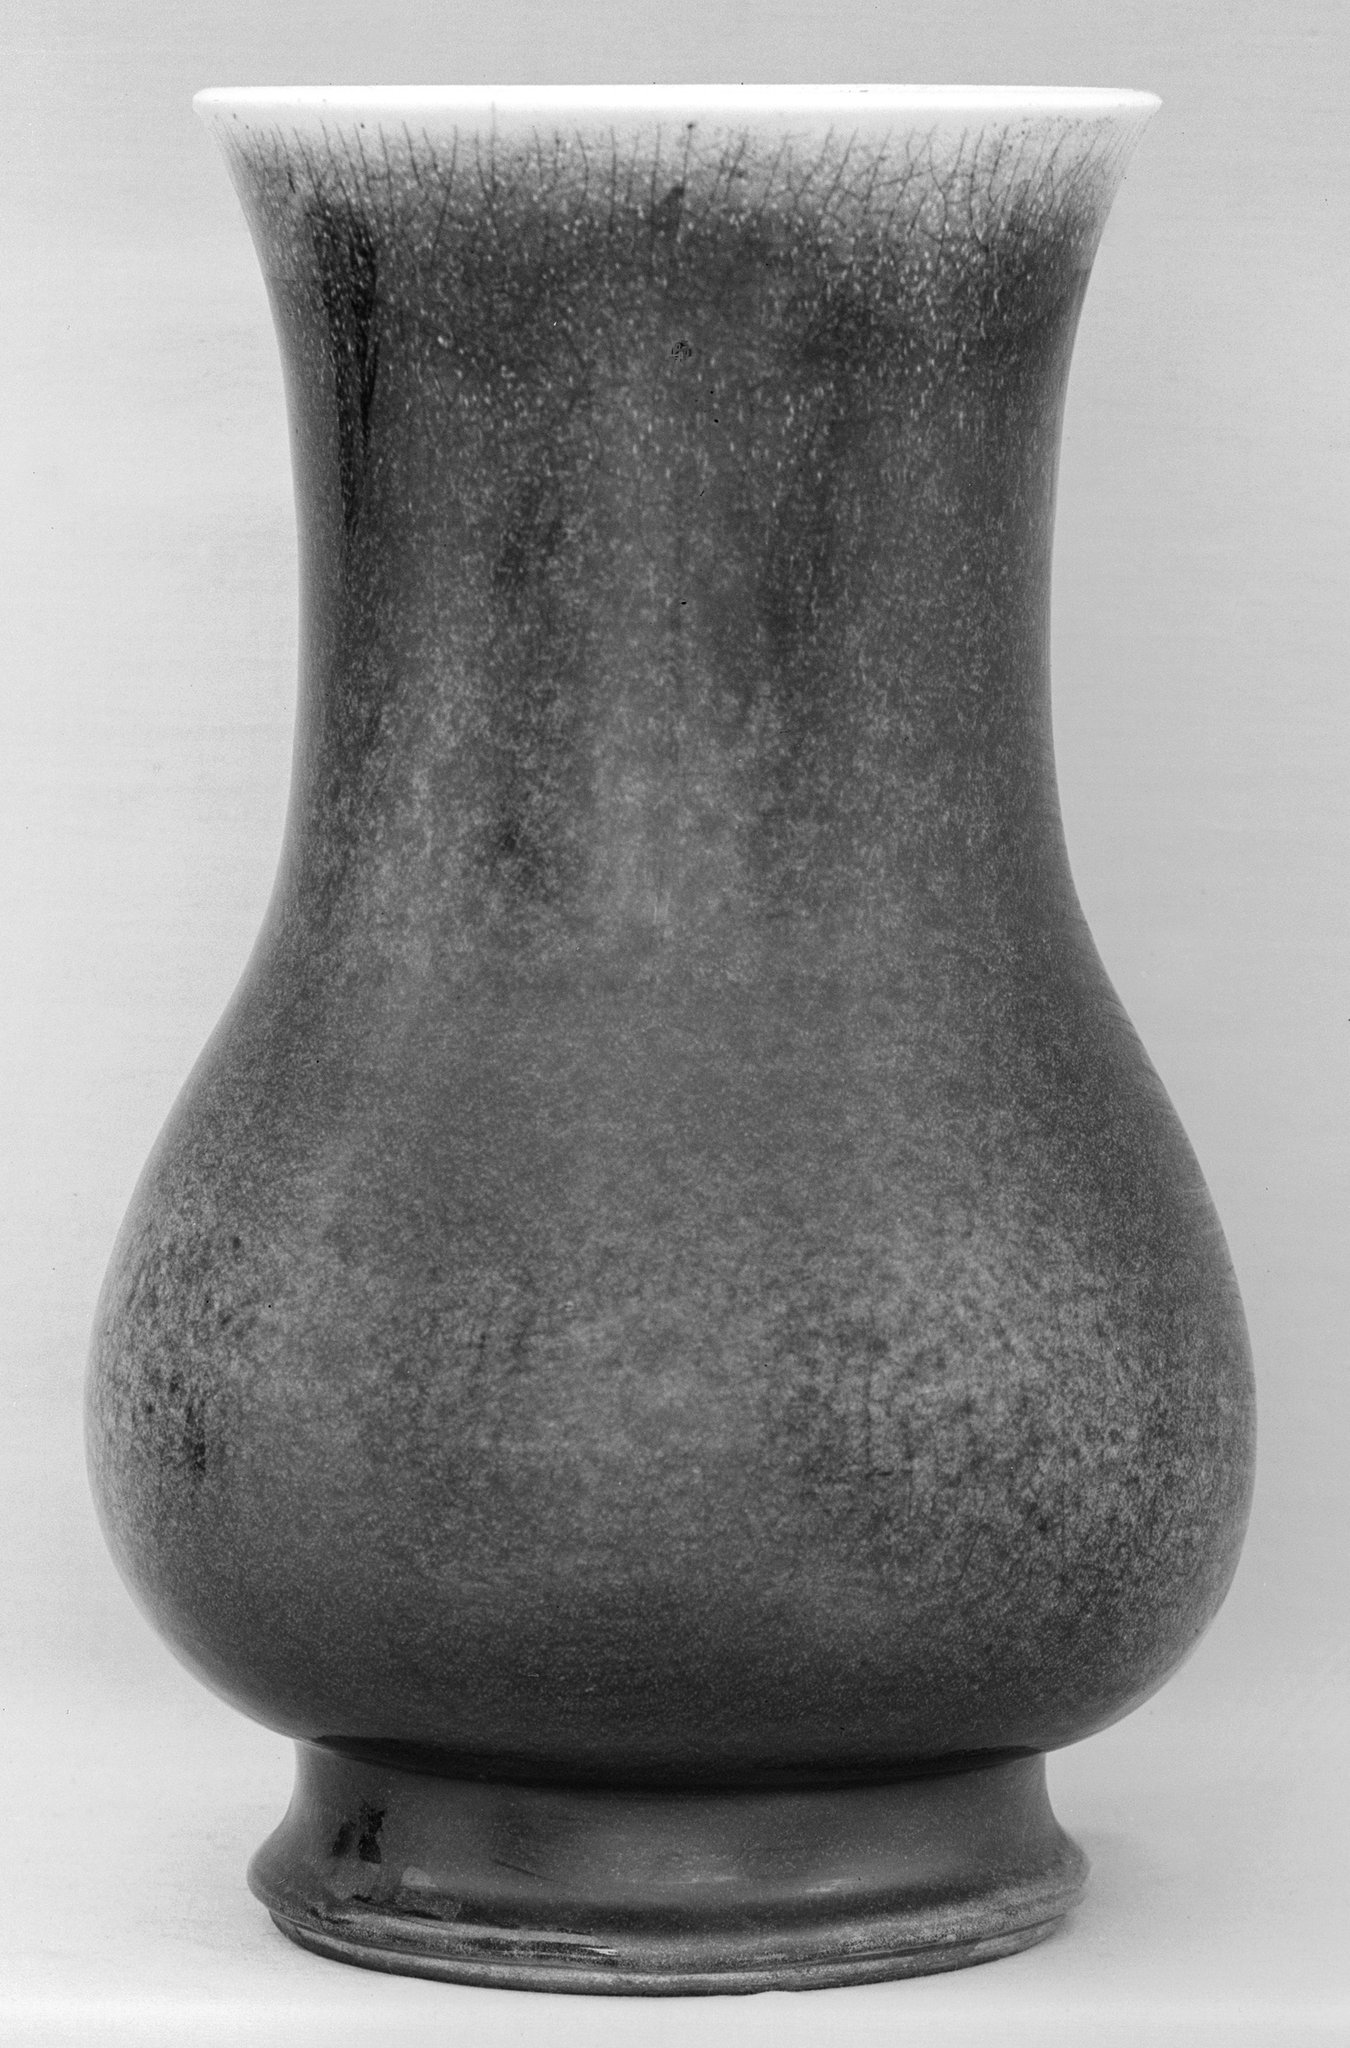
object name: jar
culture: chinese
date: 1667-1733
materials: glaze, porcelain